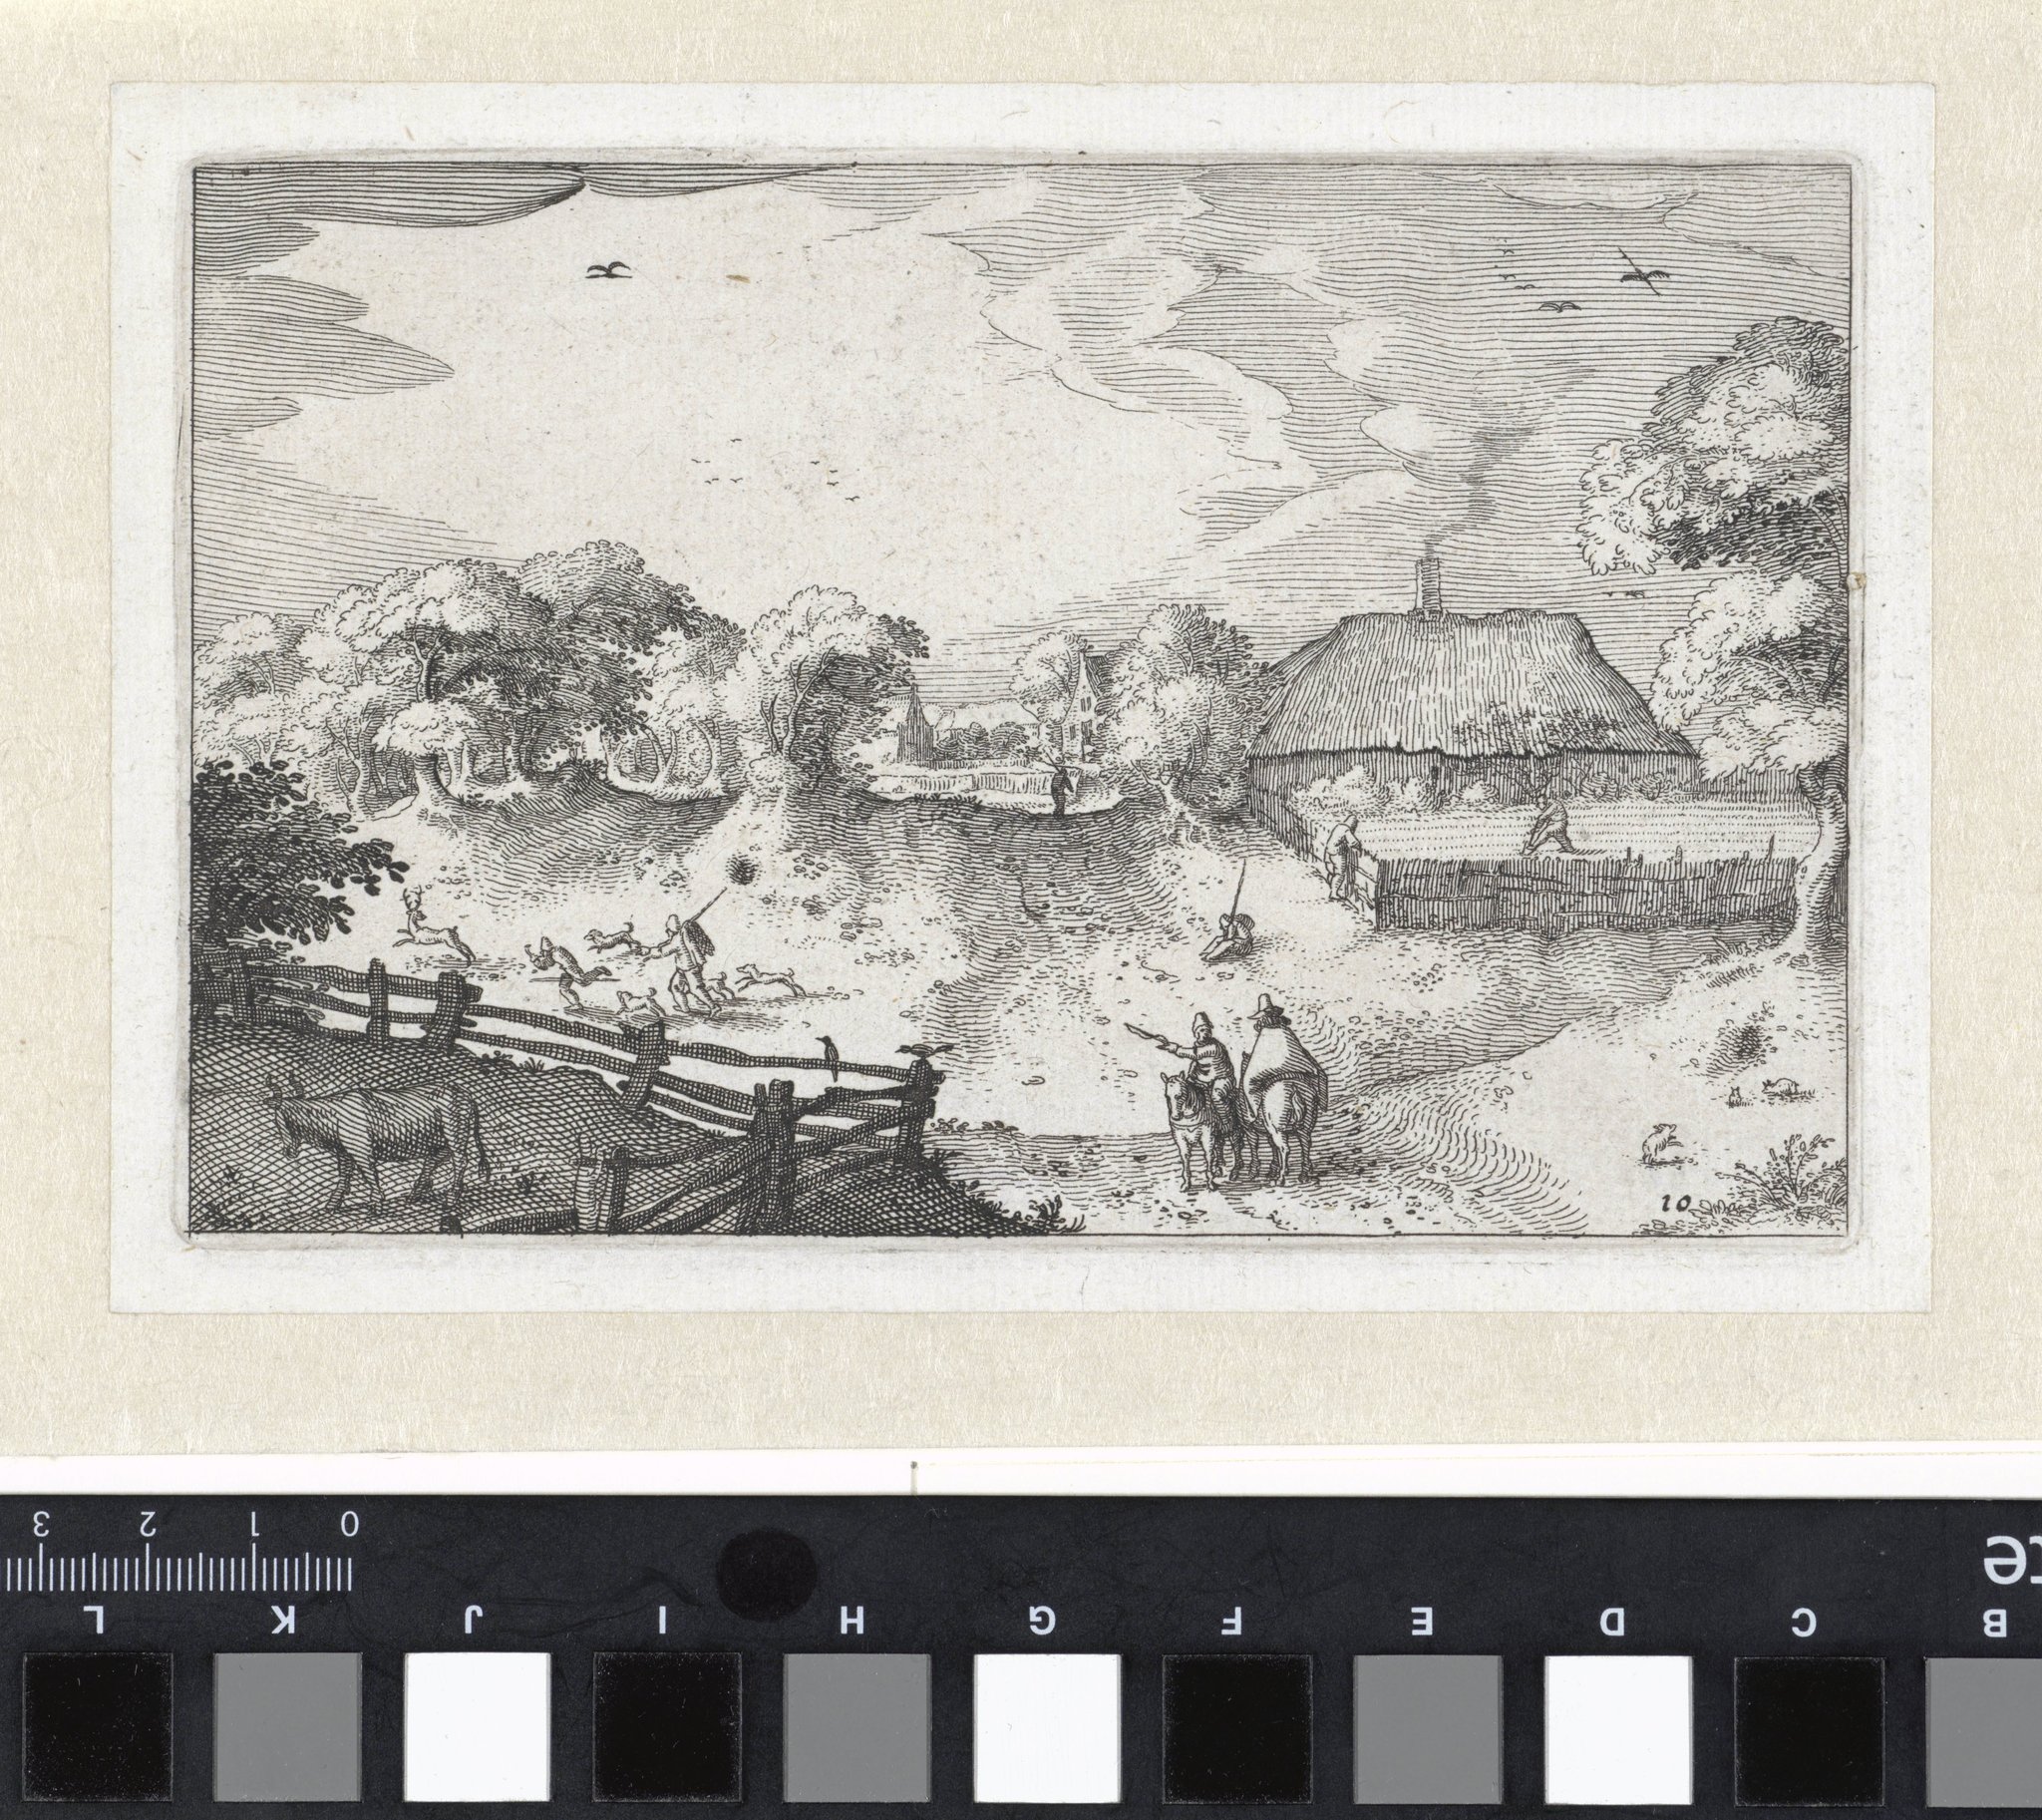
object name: print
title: Gezichten bij Haarlem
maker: claes jansz. visscher (ii)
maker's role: draughtsman, print maker, publisher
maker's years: 1586-1652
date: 1612-1652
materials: paper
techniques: etching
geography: amsterdam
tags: riding a horse, ass, or mule; rider, horseman, hoofed animals: deer, hunter, dunes (sea not visible); in the dunes, farm (building)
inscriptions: collector's mark: 2228, number: ‘10’ Lugt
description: Gezicht op een duinpad in de omgeving van Haarlem, waar twee ruiters een gesprek voeren. Rechts op de achtergrond een boerderij en links wordt gejaagd op een hert. Deze prent maakt deel uit van de serie 'Gezichten bij Haarlem'.